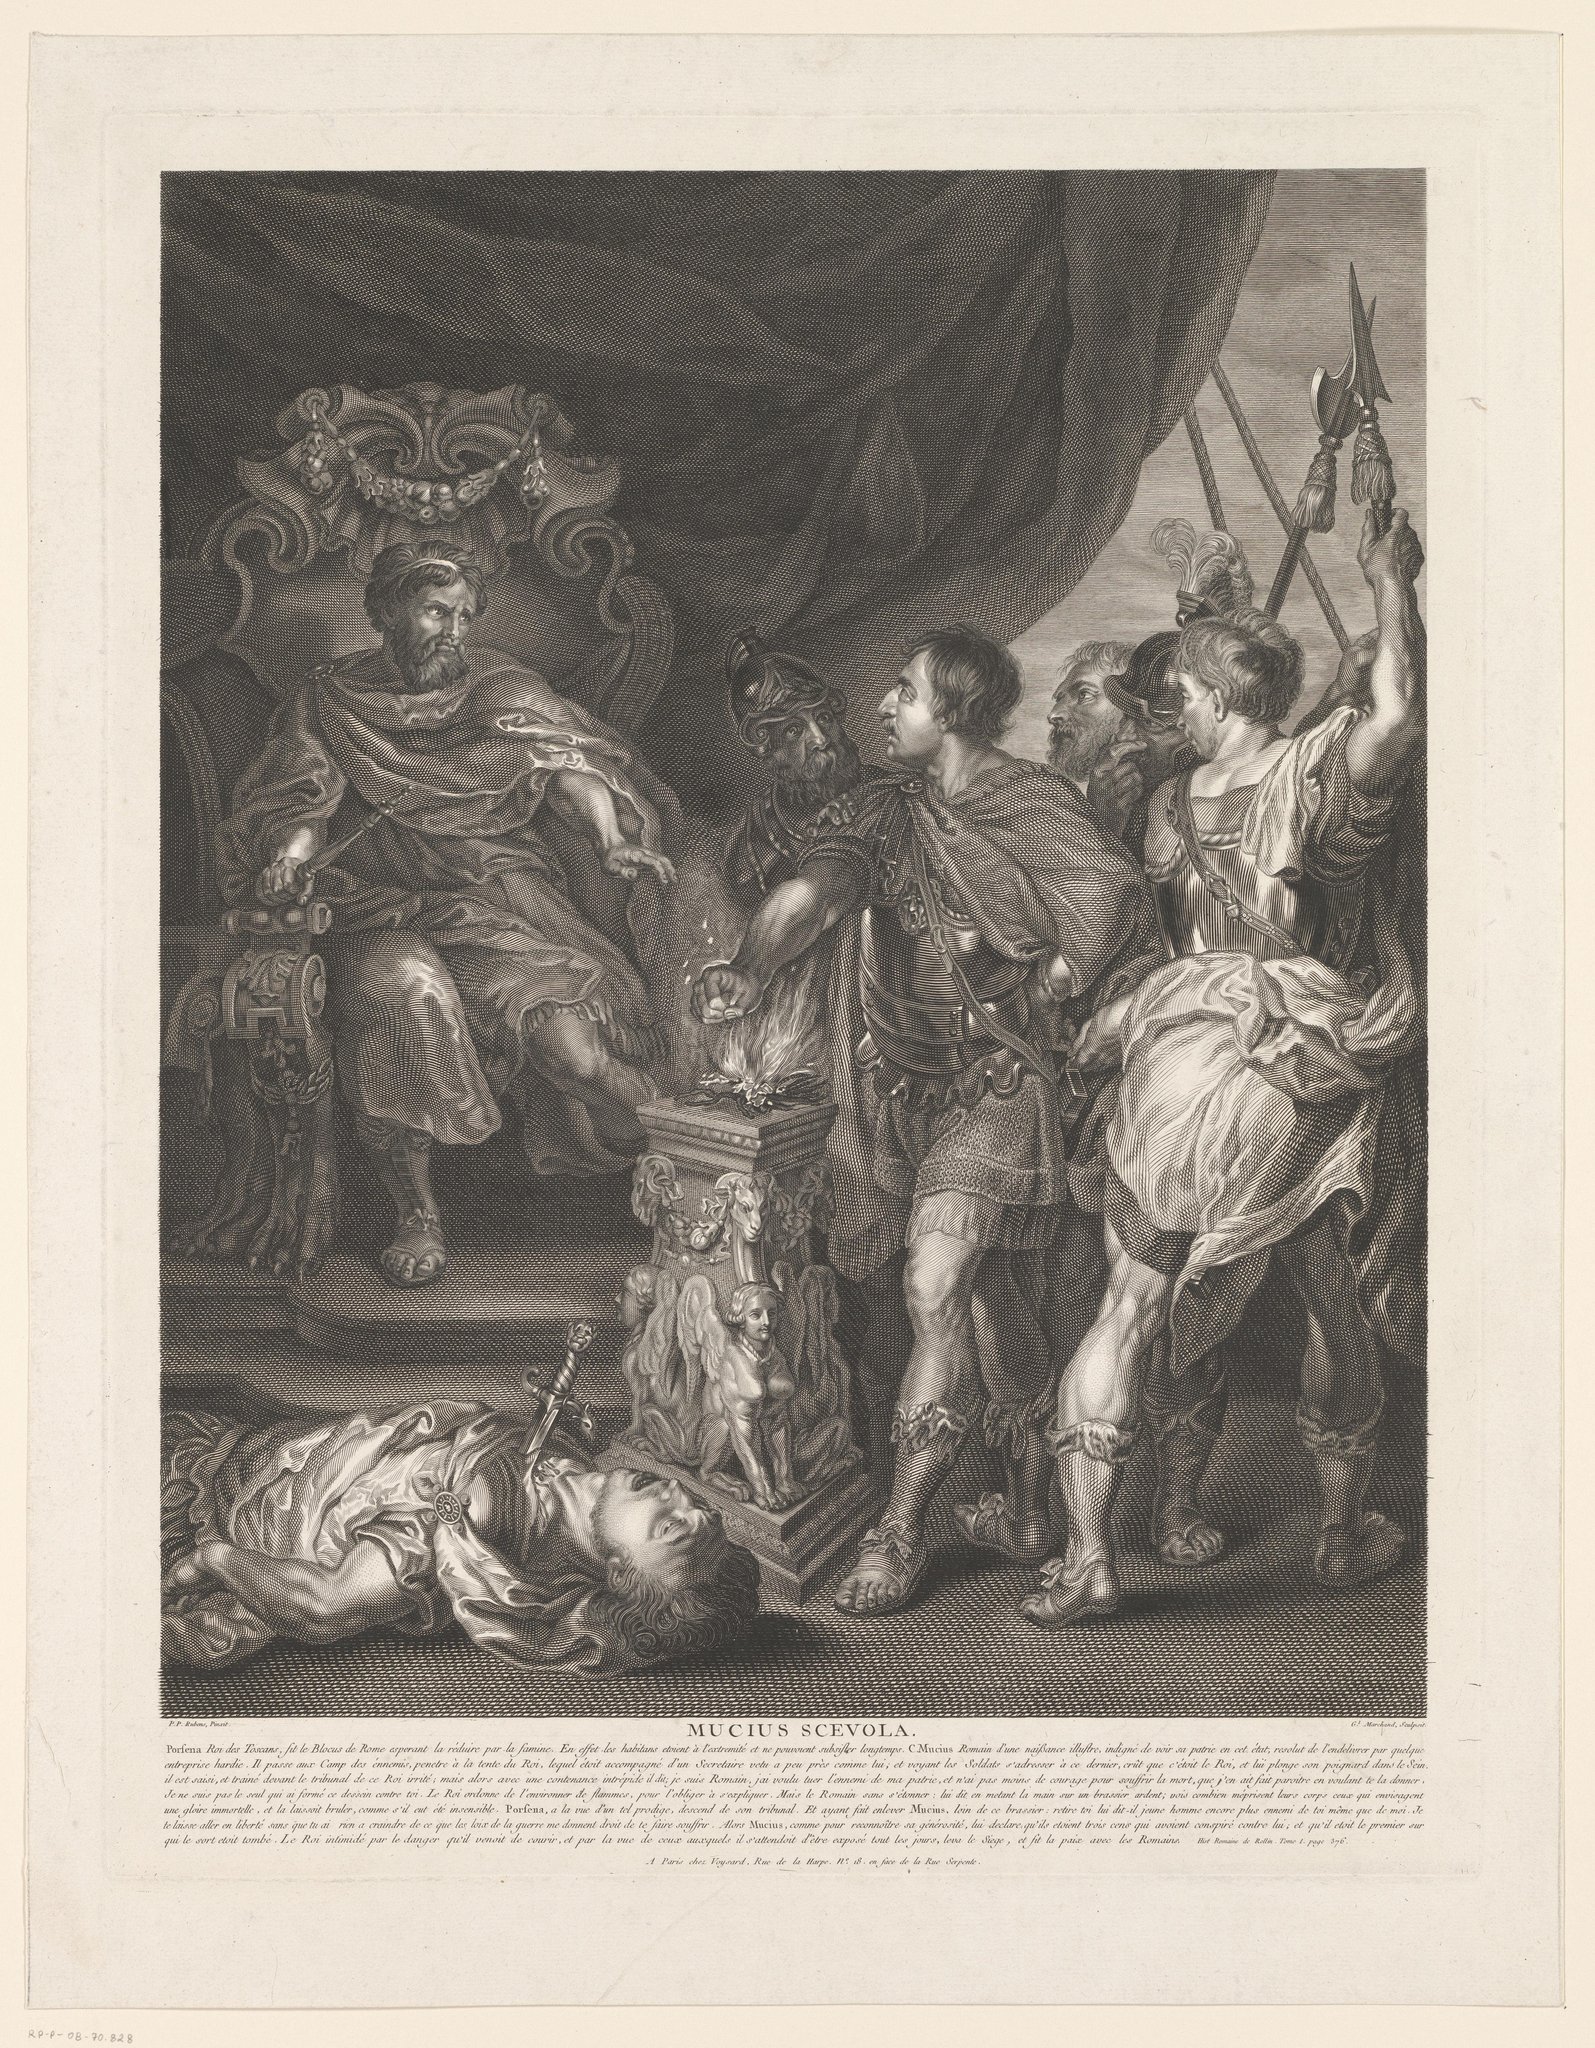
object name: print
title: Mucius Scevola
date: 1765-1855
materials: paper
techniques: engraving, etching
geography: paris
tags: gaius mucius scaevola before porsena: he thrusts his right hand into the flames (the body of the king's secretary who erroneously had been killed instead of porsena may be seen lying on the ground)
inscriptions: collector's mark: Lugt 240